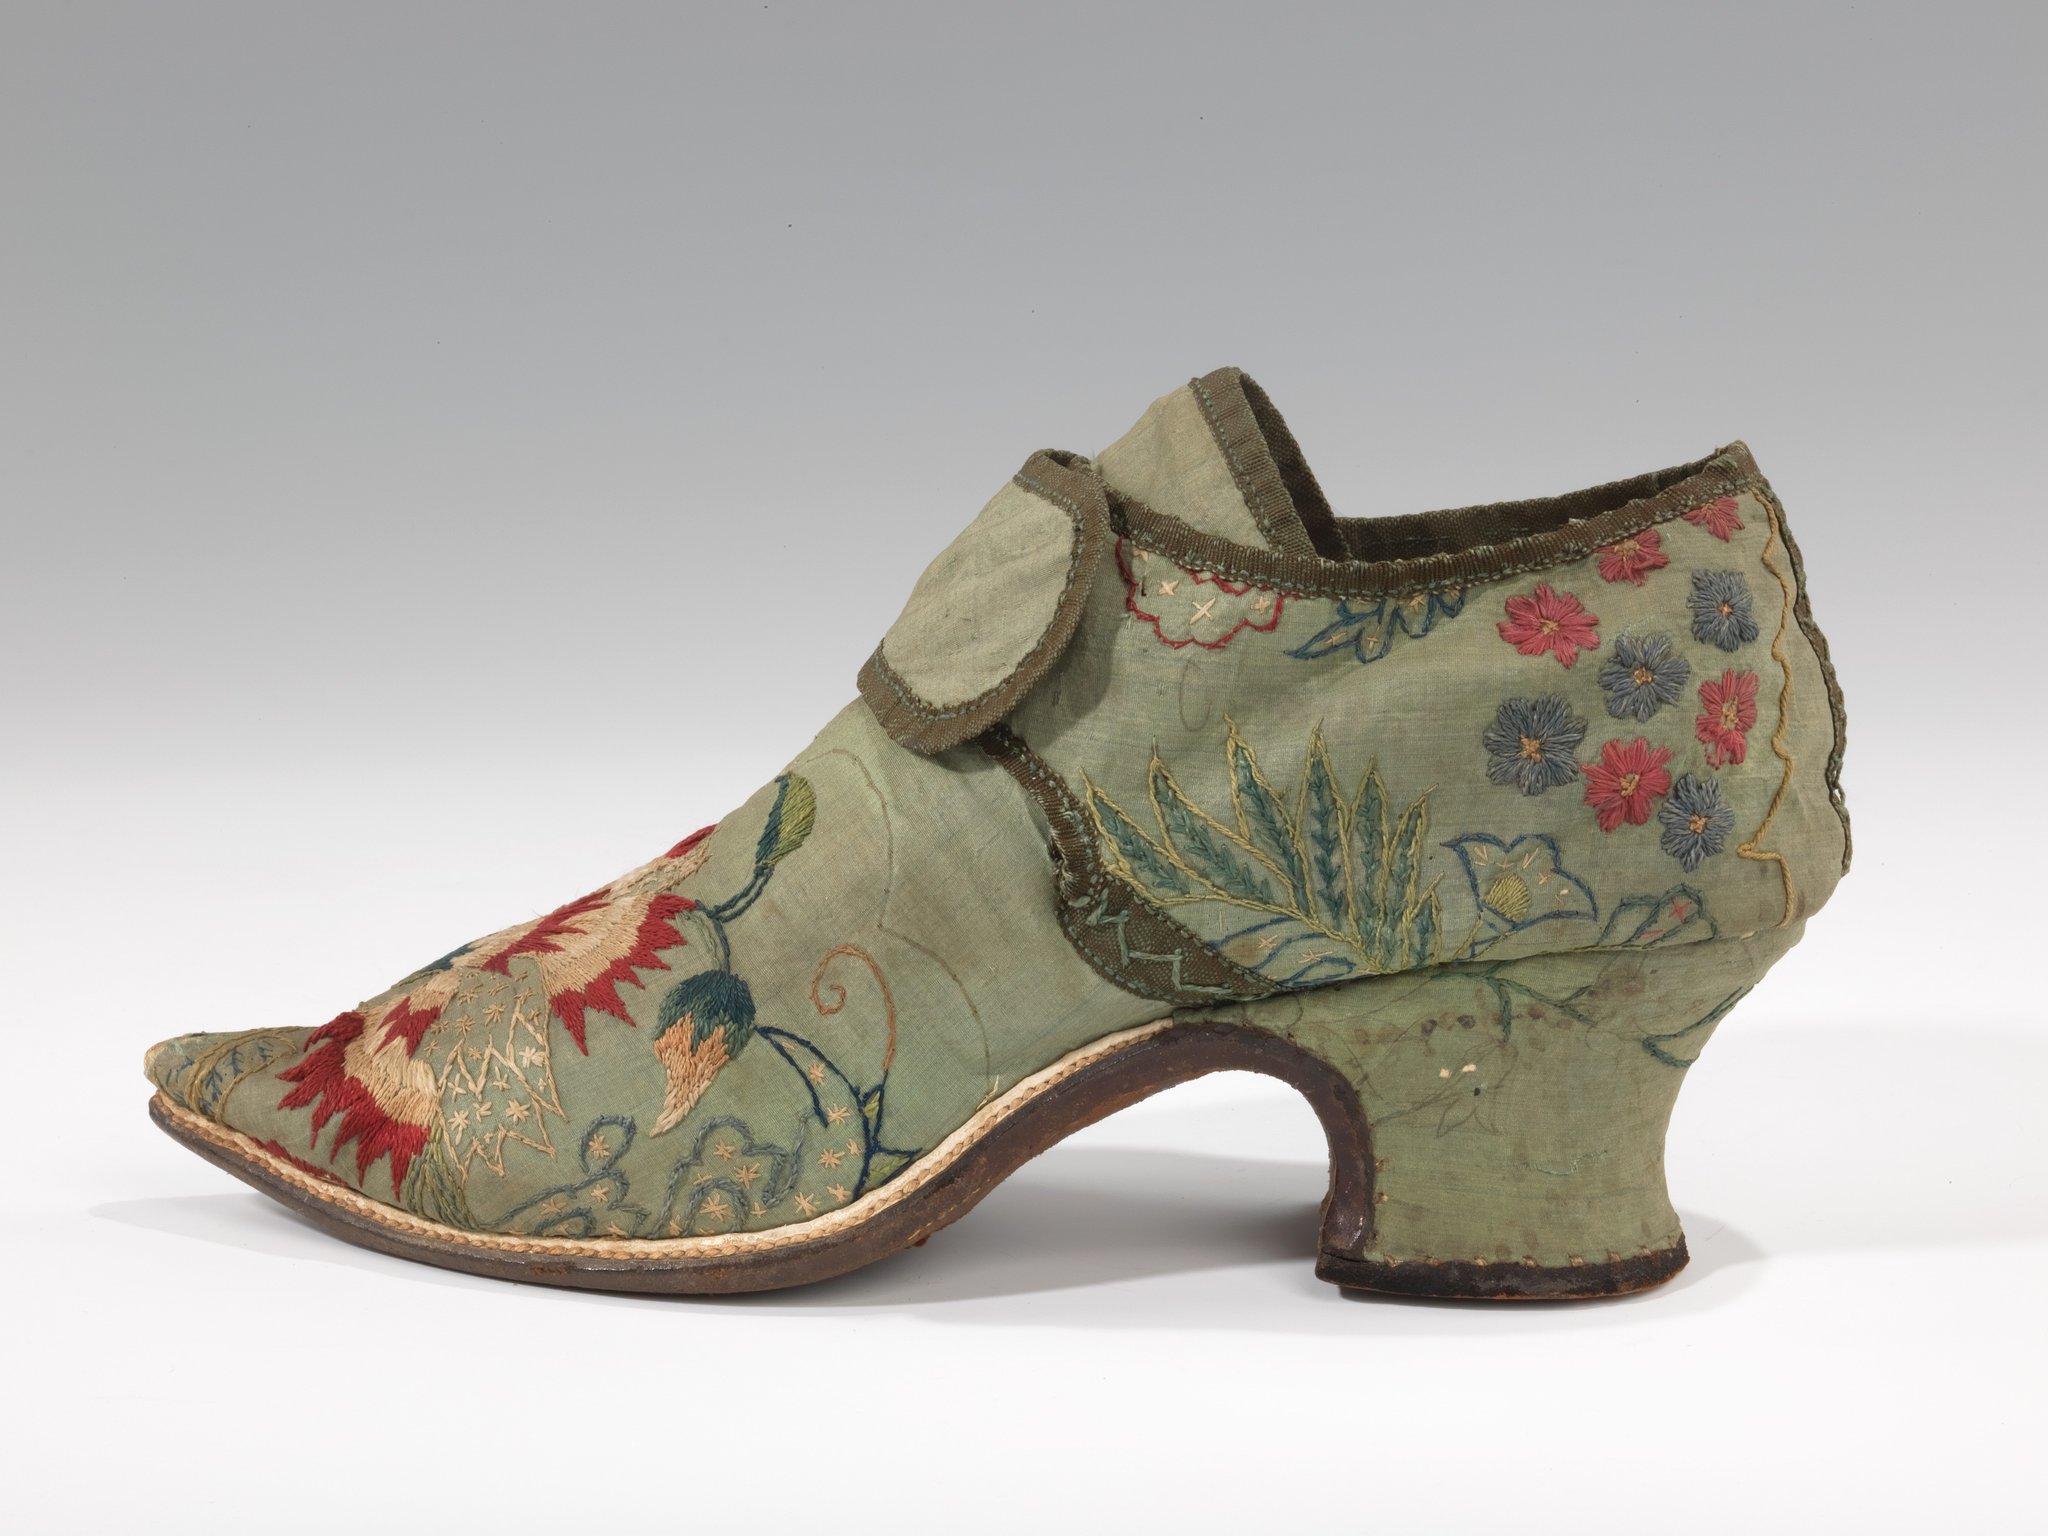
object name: shoe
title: Shoes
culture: british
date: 1720-1749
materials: silk